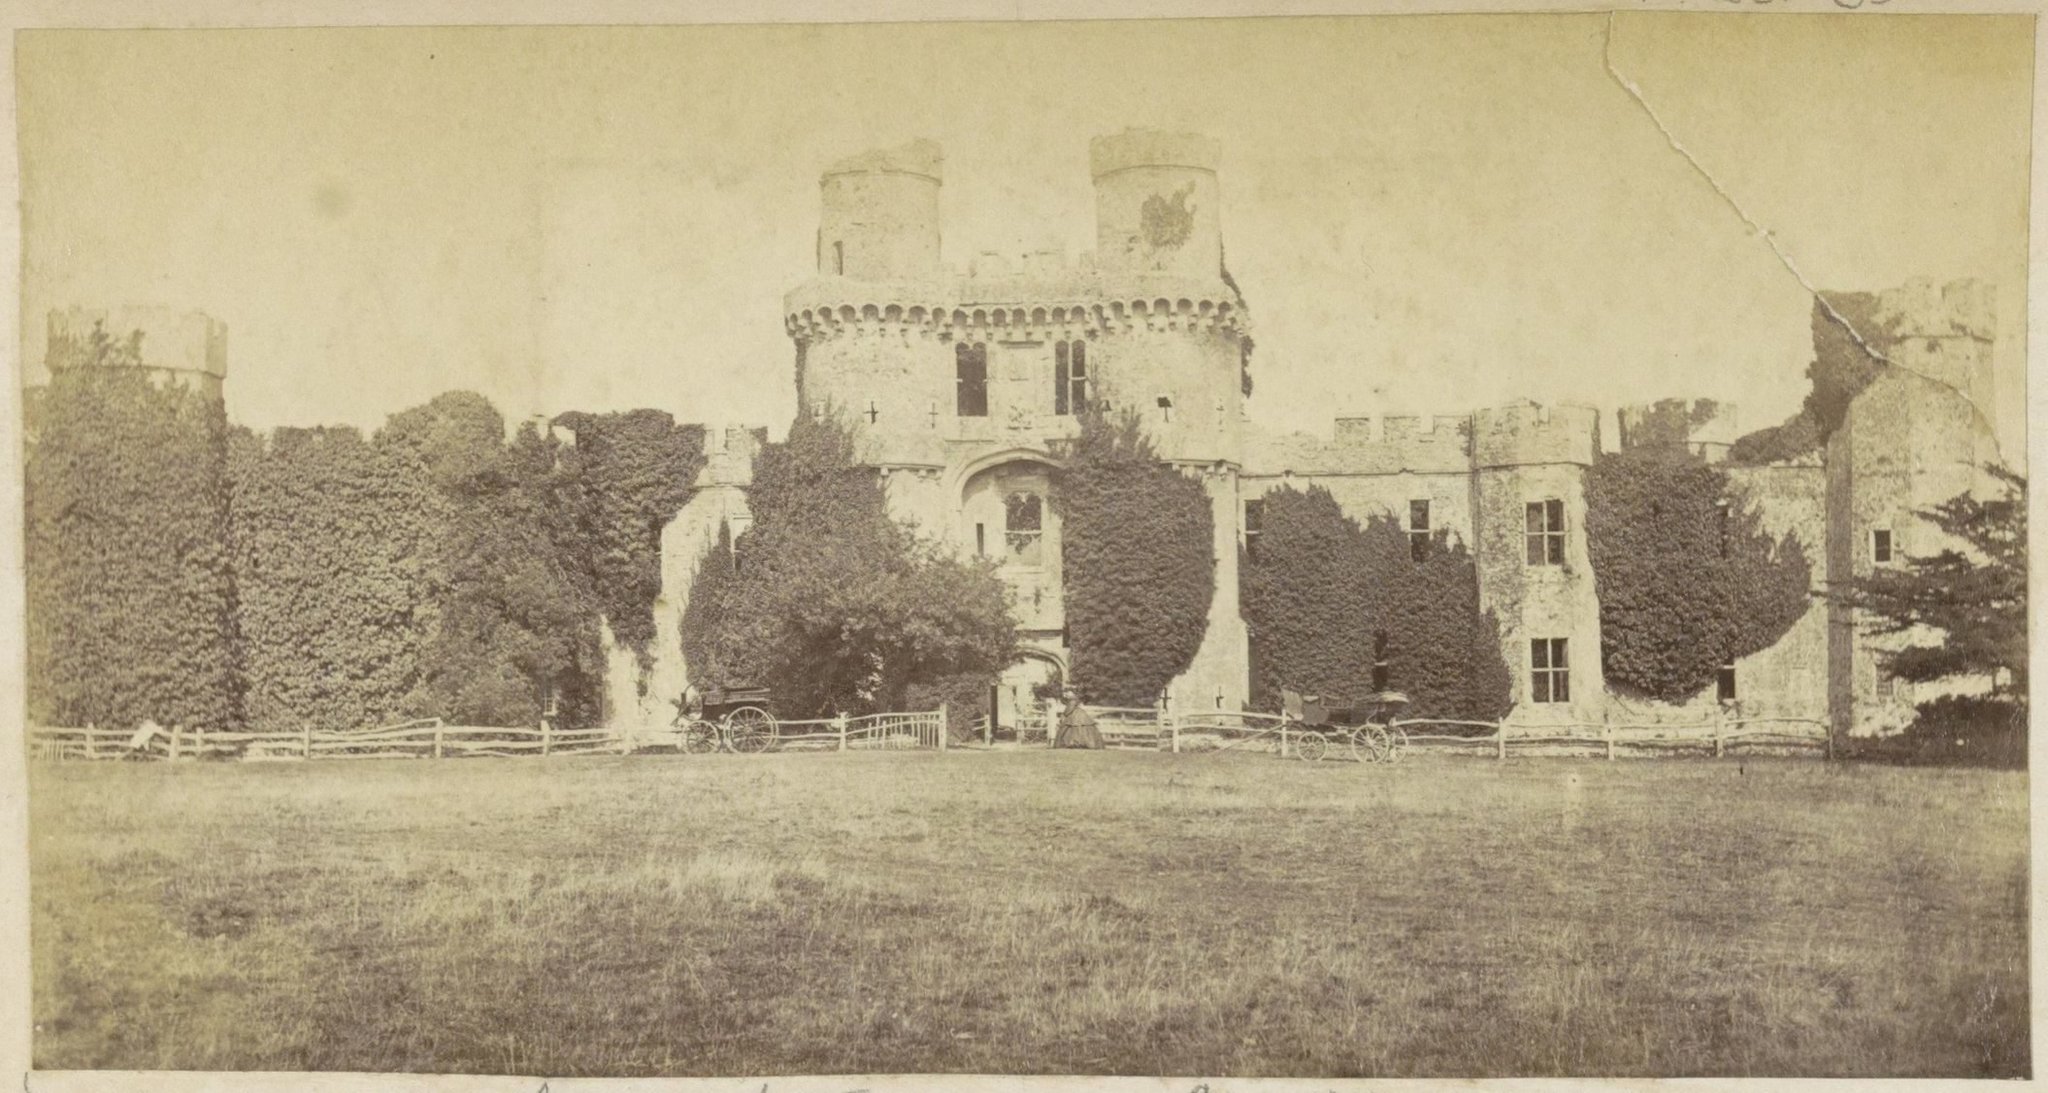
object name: photograph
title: Ruïne van Herstmonceux Castle in East Sussex met twee rijtuigen en een vrouw ervoor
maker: Anonymous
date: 1850-1870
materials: paper, photographic support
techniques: albumen print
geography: east sussex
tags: ruin of a dwelling, house, castle, etc.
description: Onderdeel van Album met foto's van bezienswaardigheden en landschappen in Engeland en van kunst.